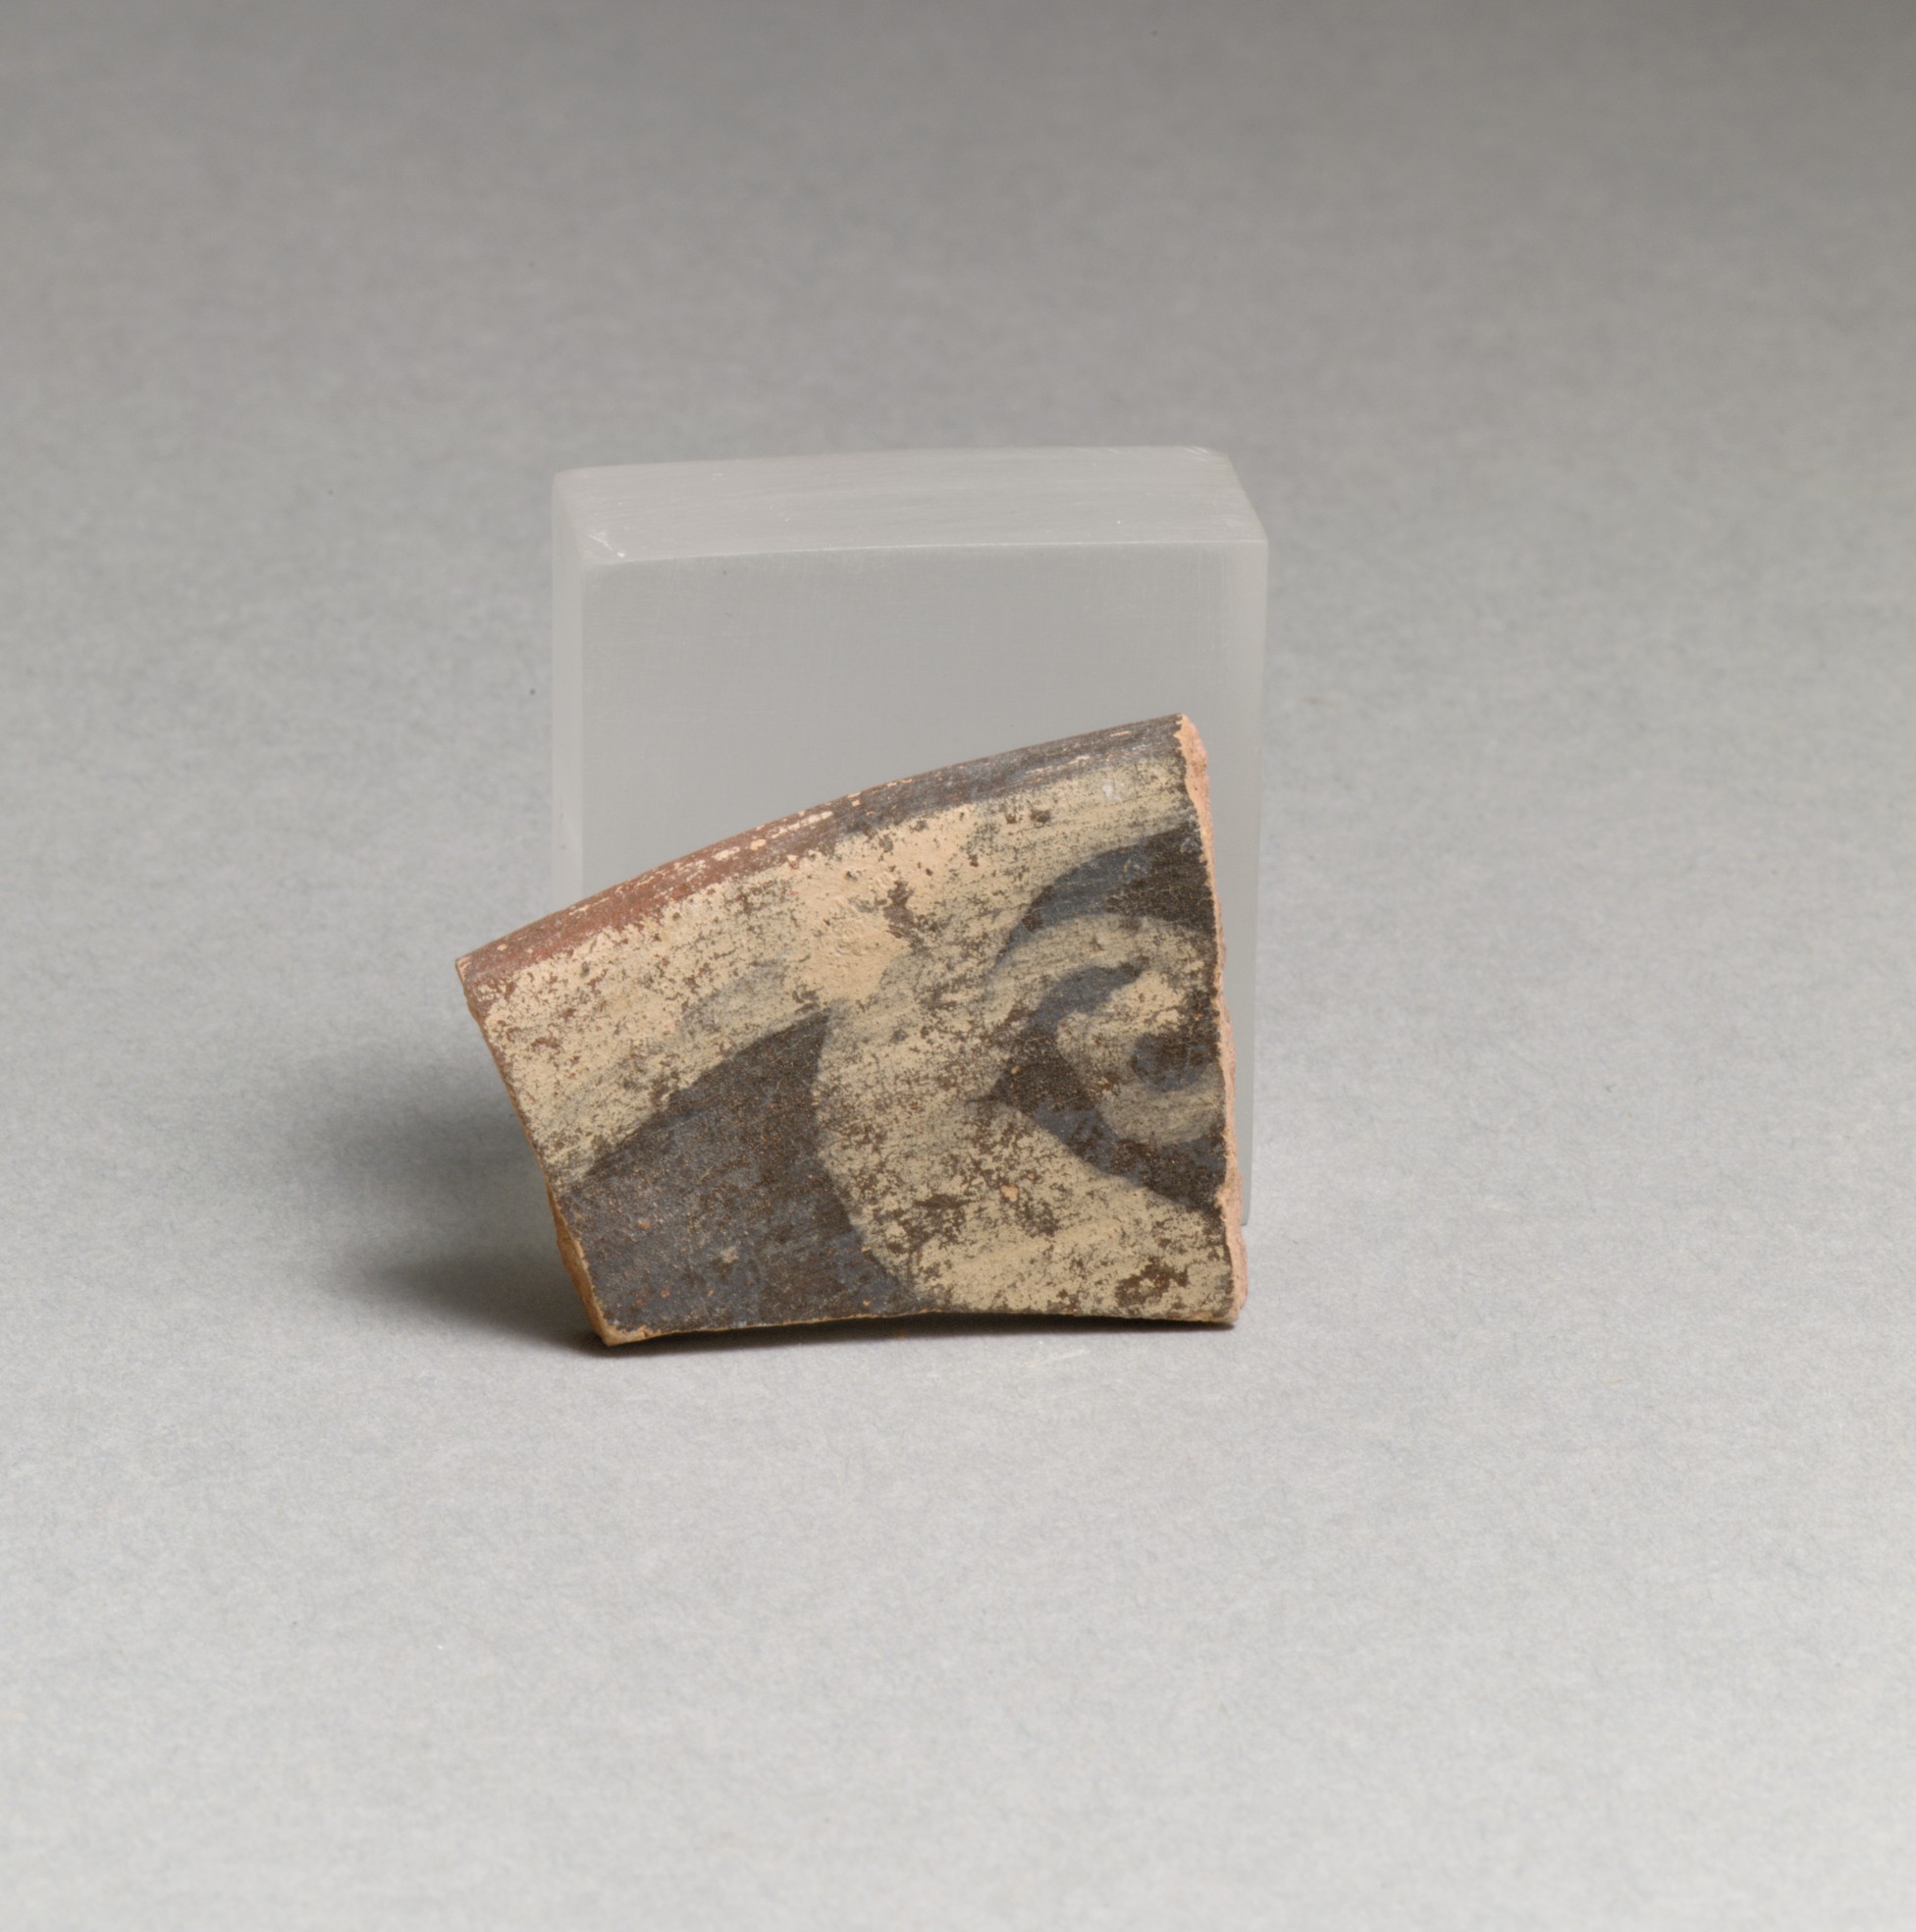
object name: vase fragment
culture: minoan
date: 2600-2000 BCE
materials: terracotta